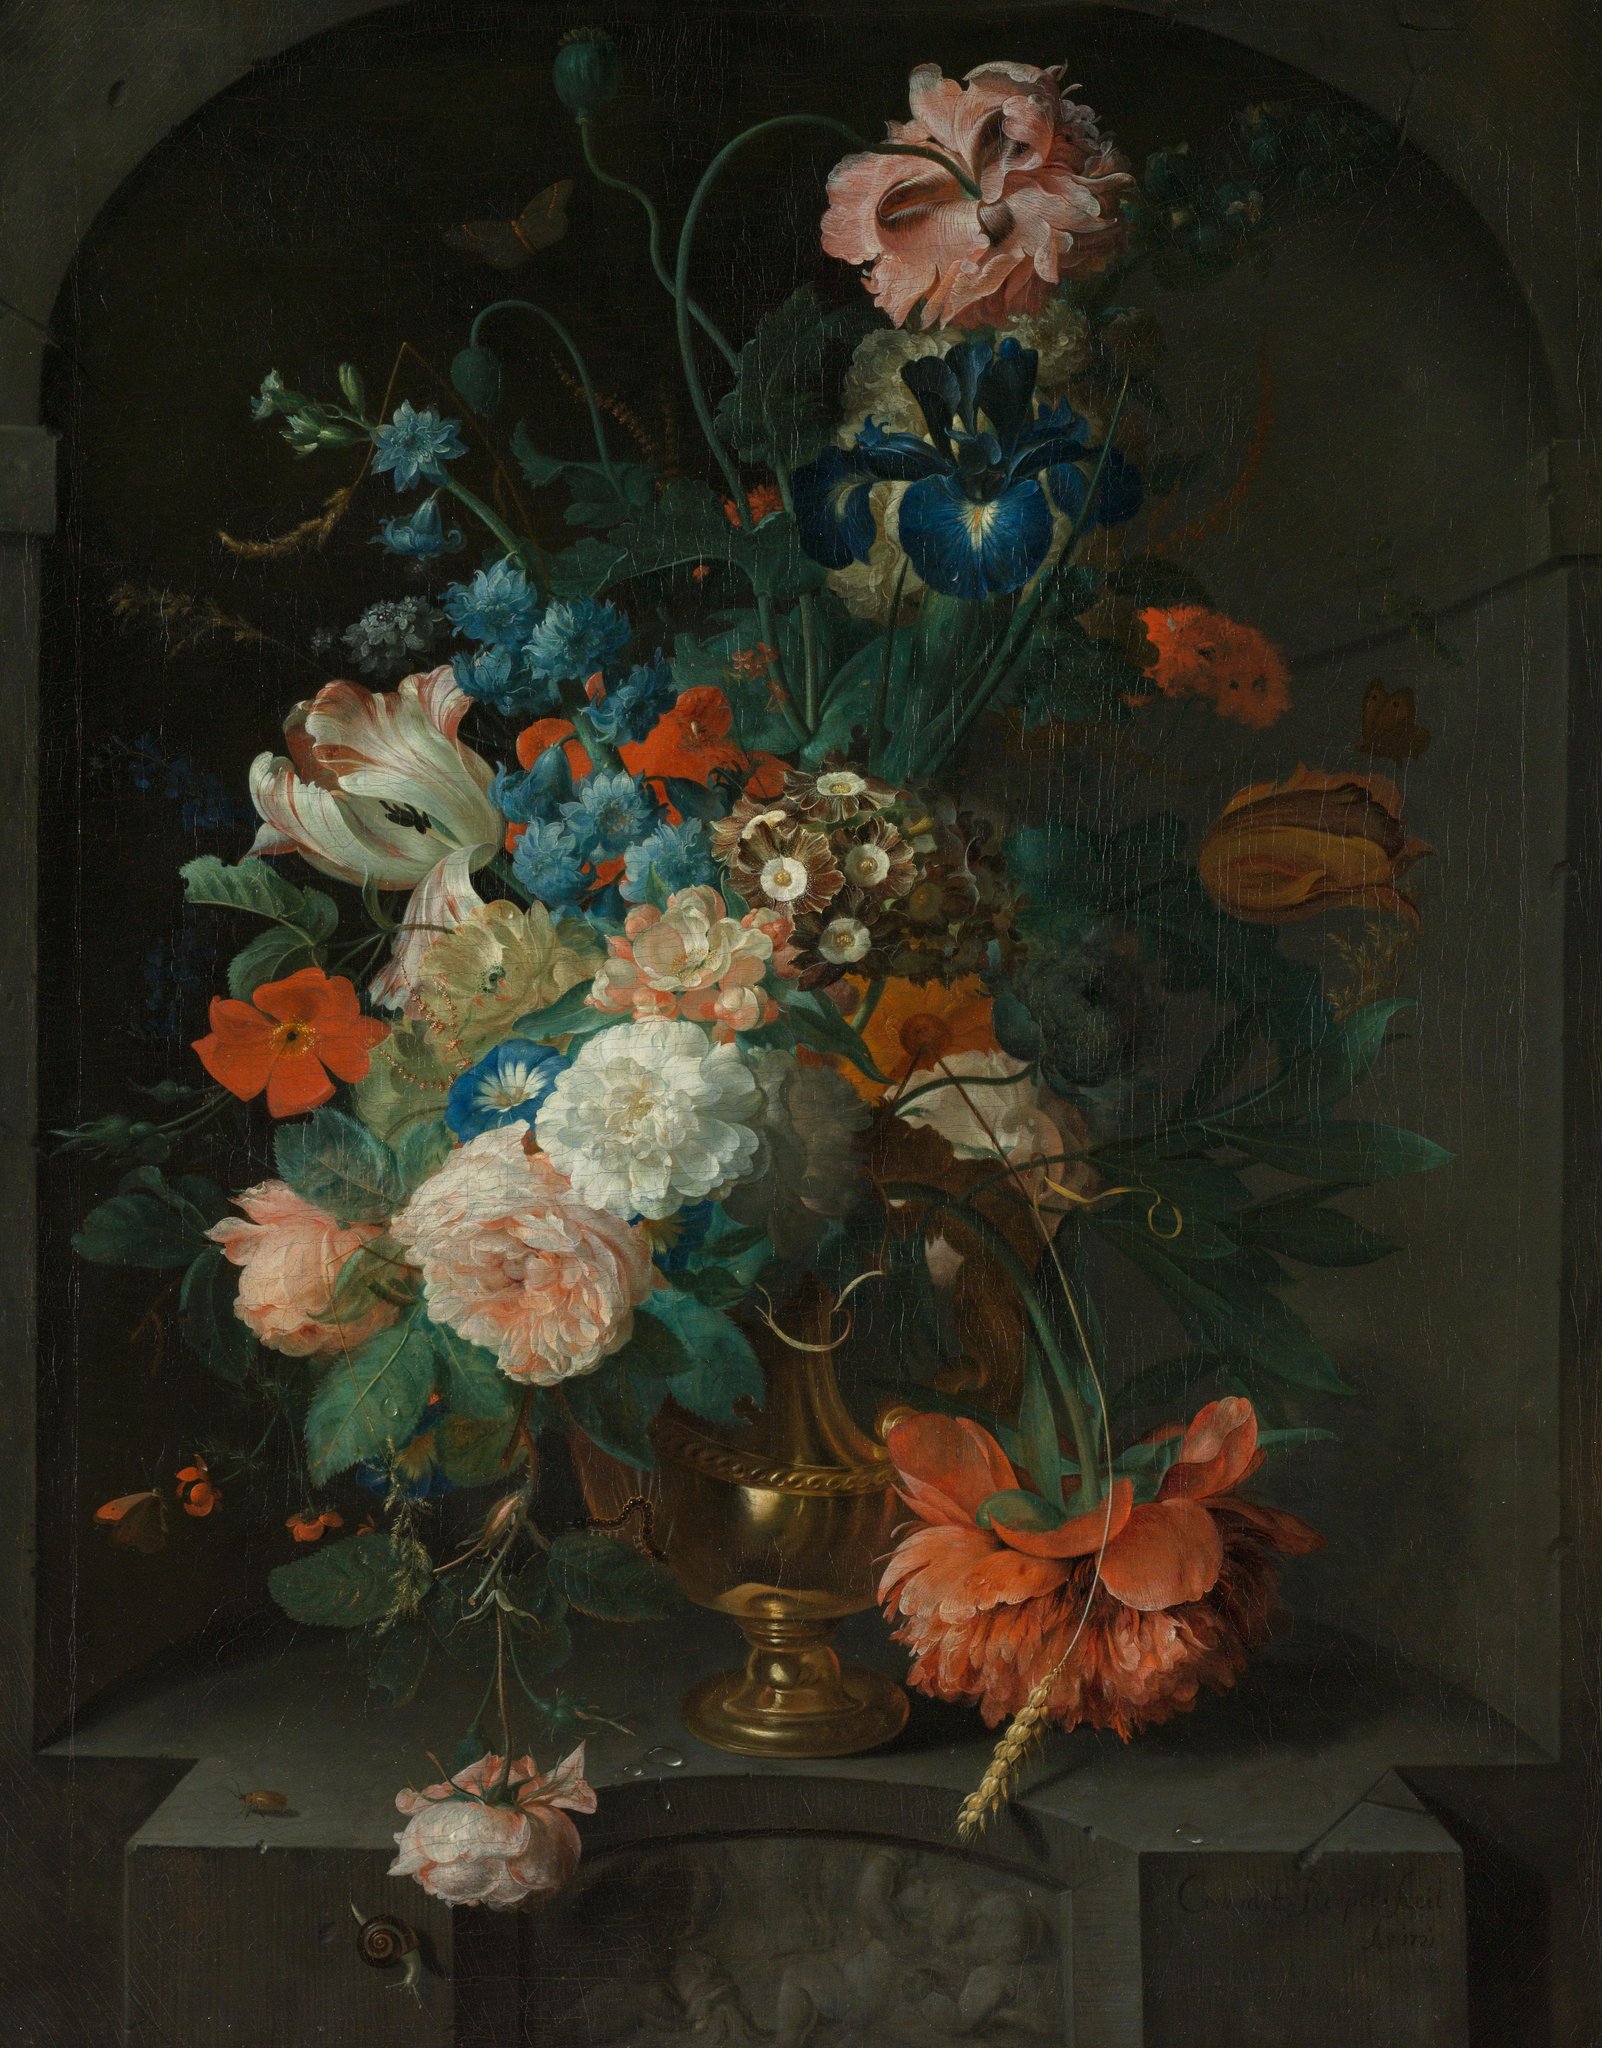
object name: painting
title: Still Life with Flowers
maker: coenraet roepel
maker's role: painter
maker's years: 1678-1748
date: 1721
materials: canvas, oil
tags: flowers in a vase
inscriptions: signature and date: ‘Coenraet Roepel fecit Aº 1721’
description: Stilleven met bloemen. Een boeket bloemen in een metalen vaas staande in een nis. In het boeket zitten rozen, irissen, papavers, een tarwehalm, tulpen en ander bloemen. Tussen de bloemen en over de nis kruipen een slak, een rups en een kever. Pendant van SK-A-337.